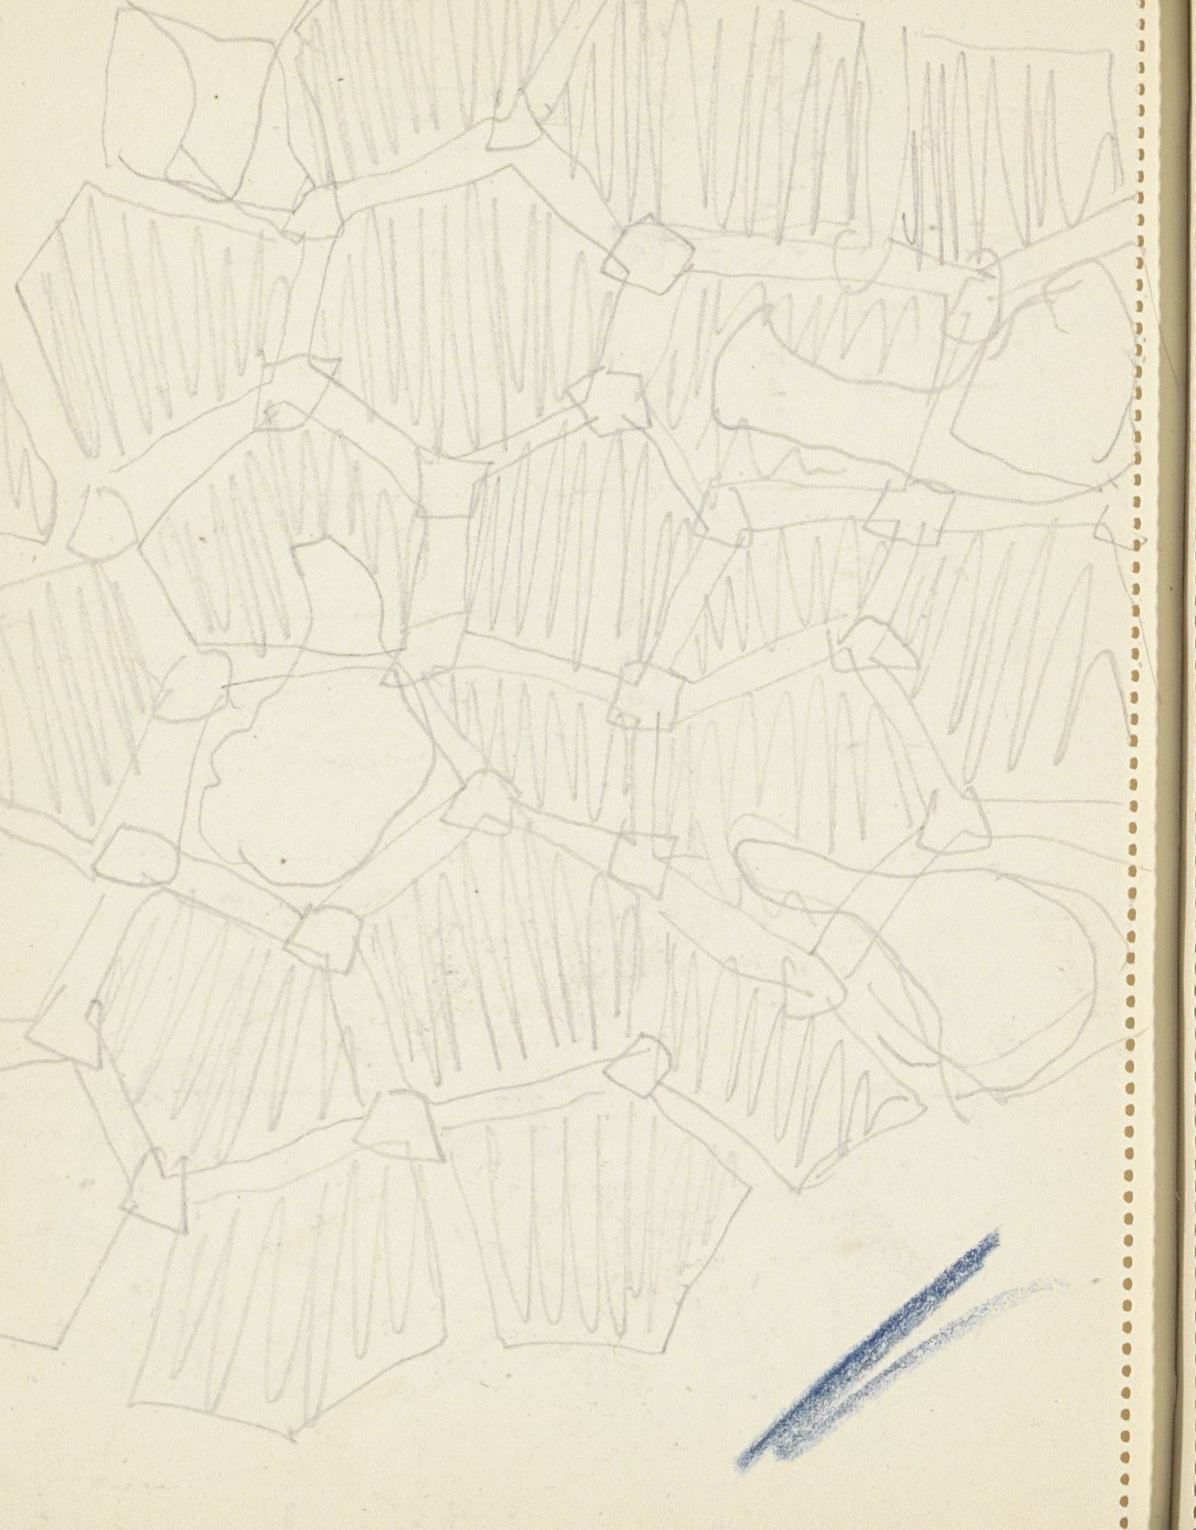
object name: sketchbook leaf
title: Decoratief patroon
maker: reijer stolk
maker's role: draughtsman, print maker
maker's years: 1896-1945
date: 1916-1945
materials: paper, pencil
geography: africa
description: Blad 46 verso uit een schetsboek met 60 bladen.